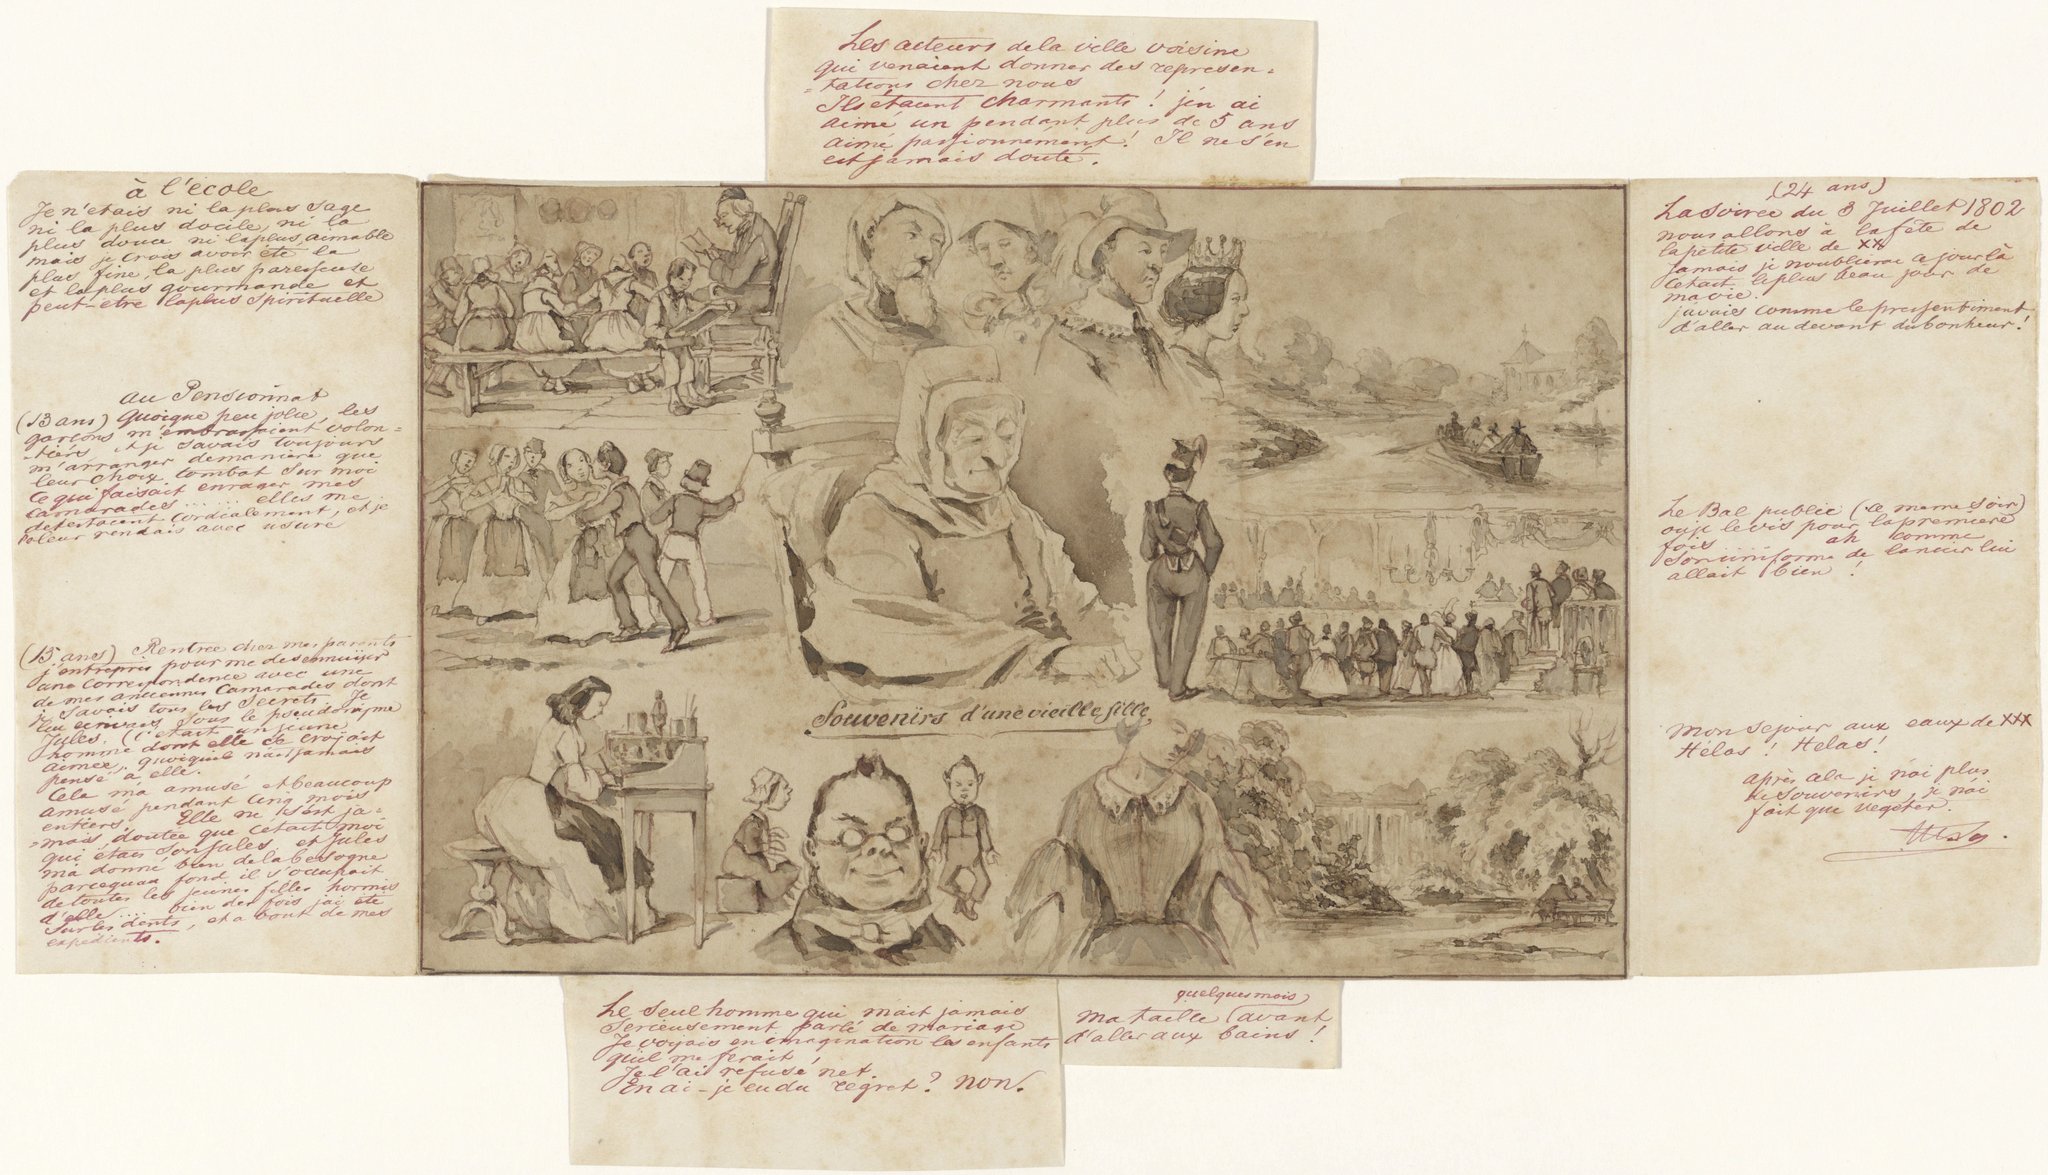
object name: caricature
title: Karikaturale voorstelling met scènes uit het leven van een vrouw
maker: pieter van loon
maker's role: draughtsman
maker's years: 1801-1873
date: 1811-1873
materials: ink, paper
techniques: brush, pen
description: Karikaturale voorstelling met scènes uit het leven van een vrouw; met opschrift in het midden en bijschriften op aan de tekening geplakte stukken papier.